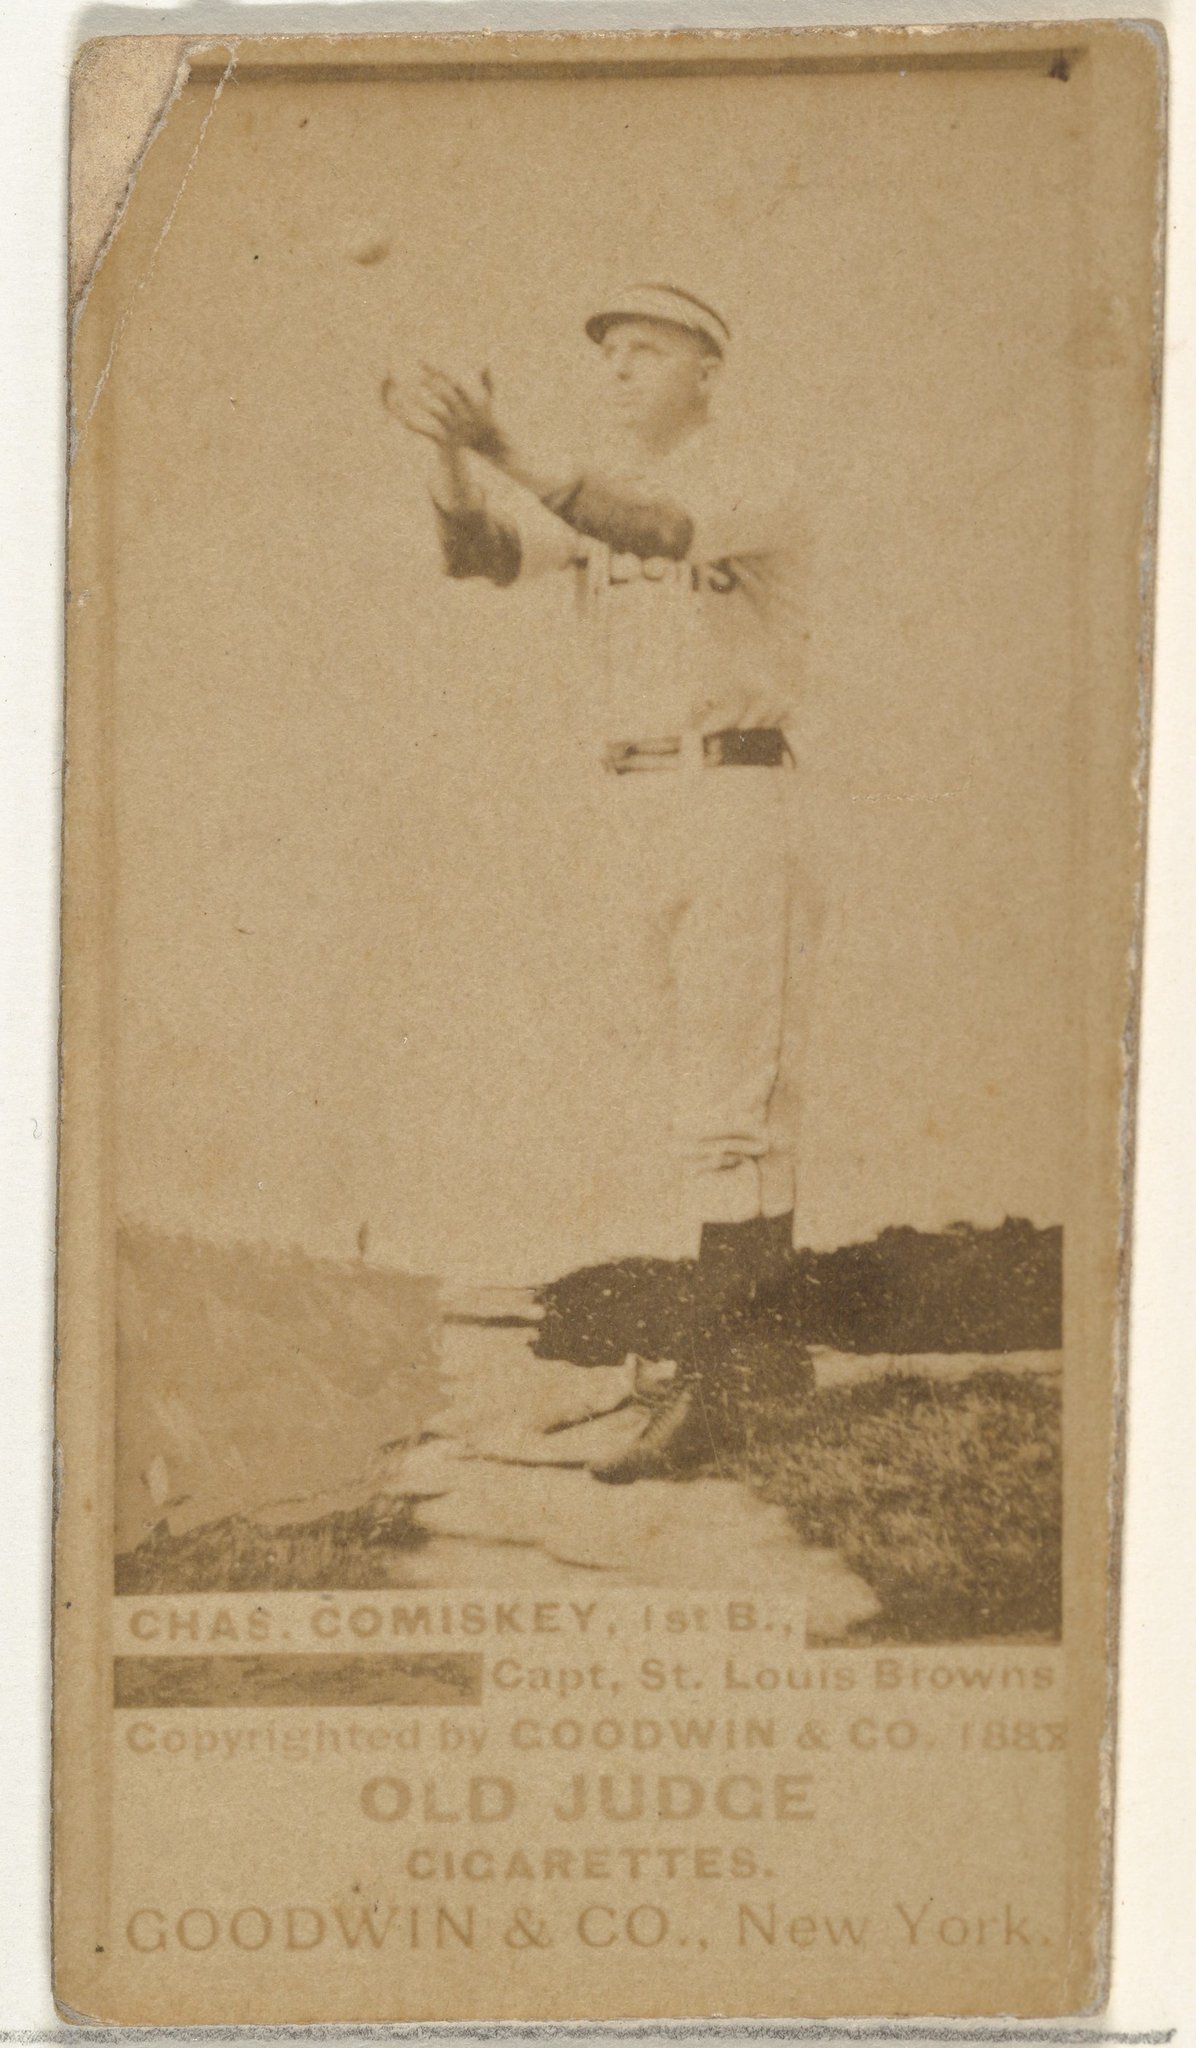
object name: baseball card, photograph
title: Charles Albert "The Old Roman" Comiskey, 1st Base and Manager, St. Louis Browns, from the Old Judge series (N172) for Old Judge Cigarettes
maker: goodwin & company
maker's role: publisher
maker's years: 1850-1950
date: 1888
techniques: albumen silver print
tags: men,portraits,baseball,athletes